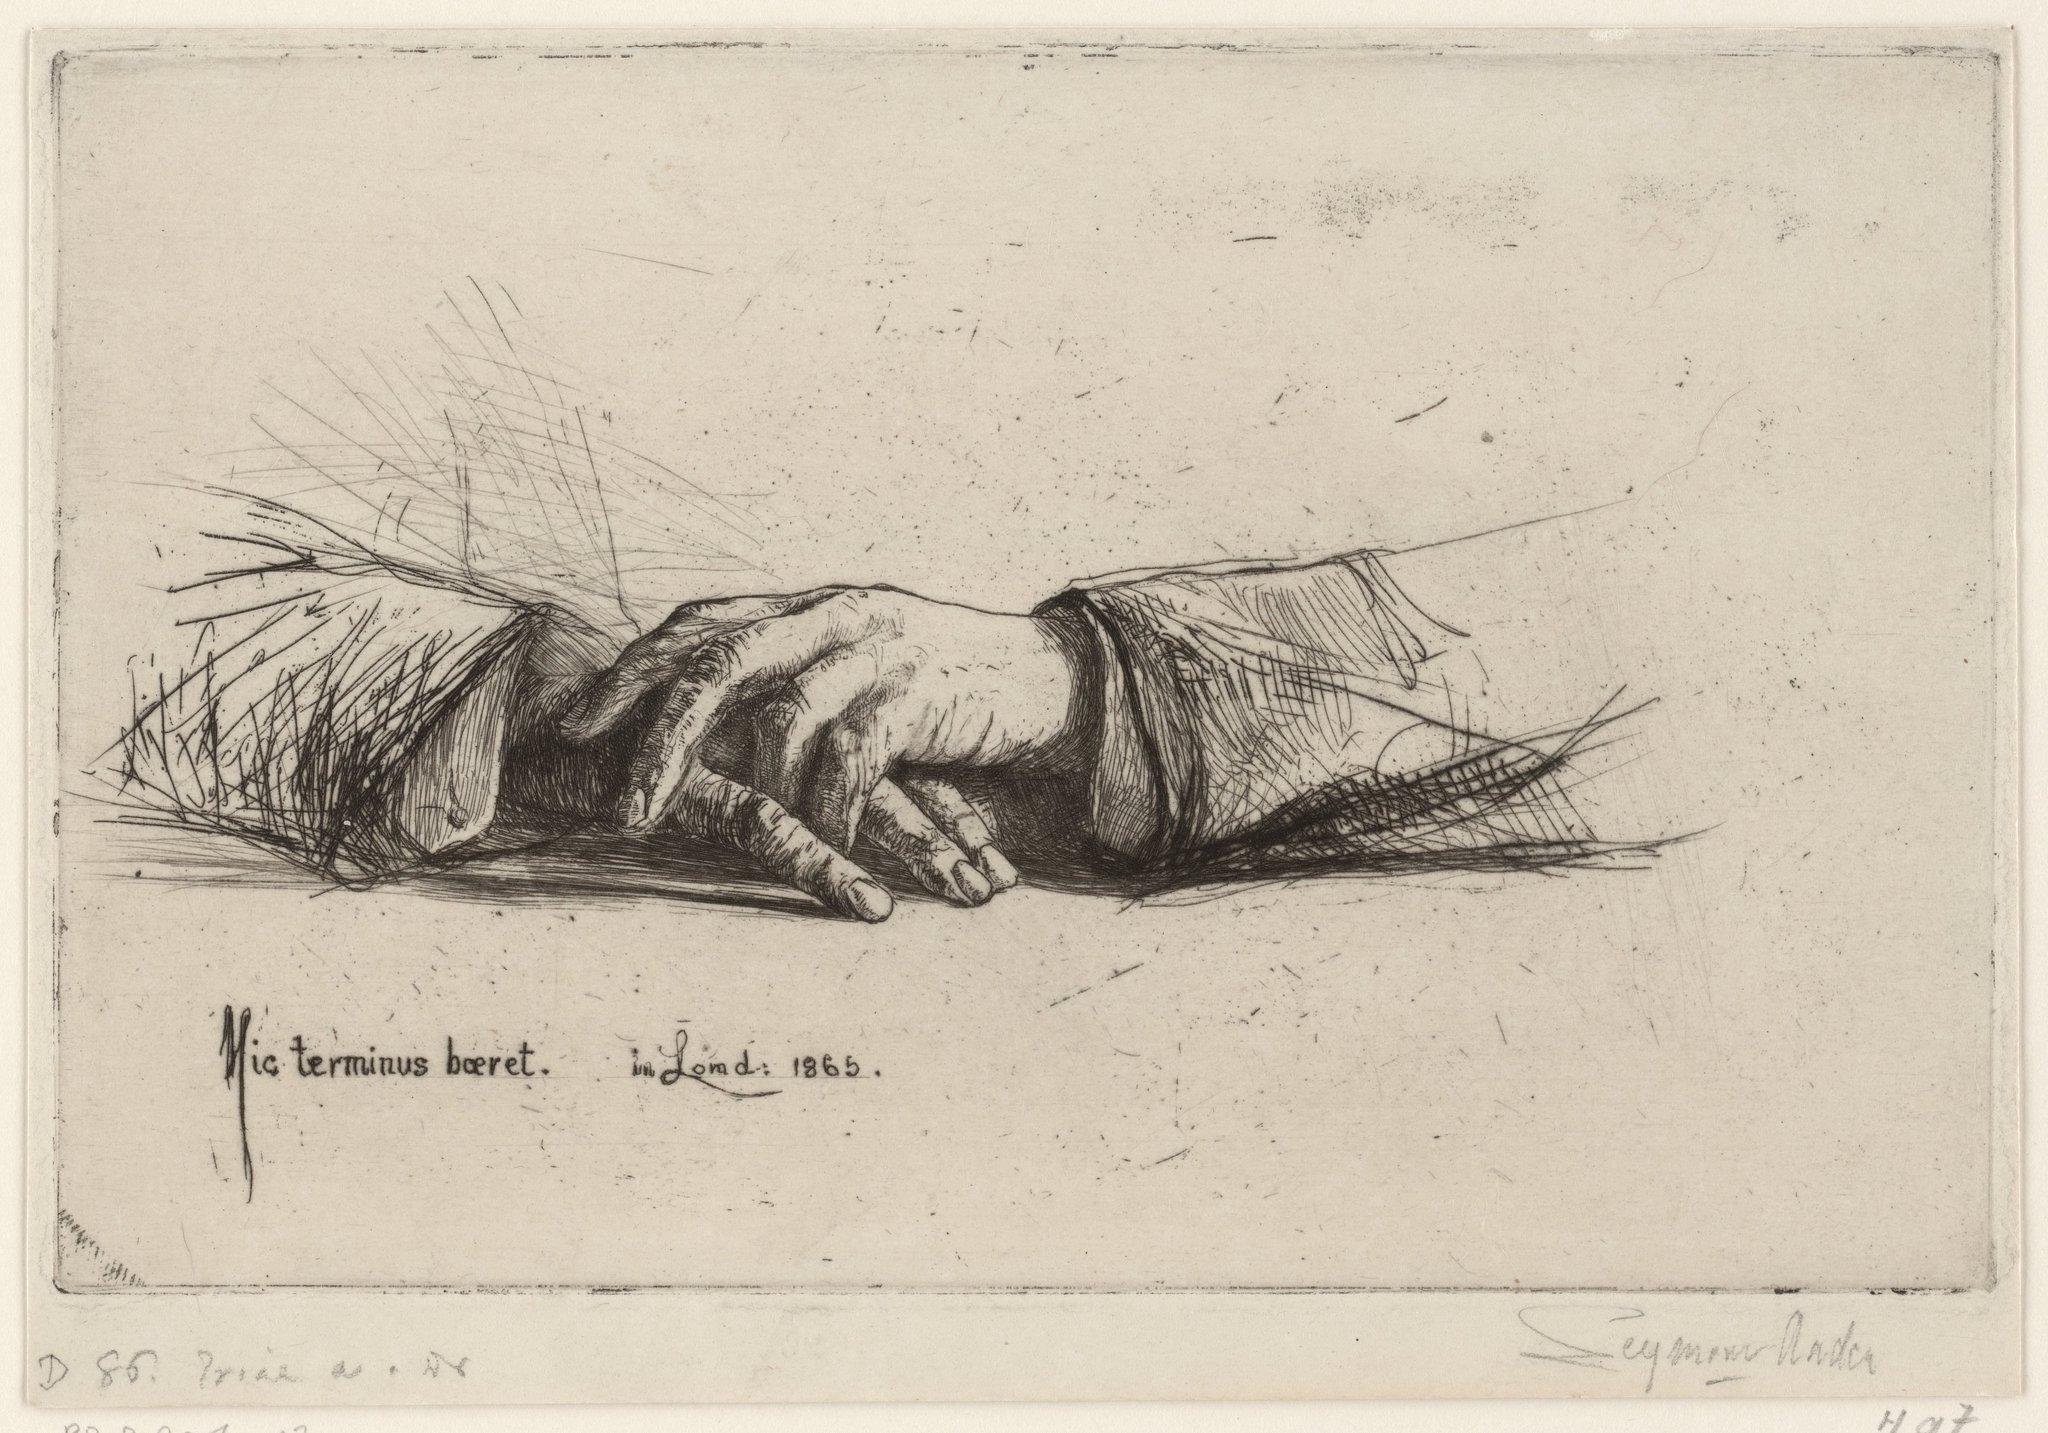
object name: print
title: Etudes à l'eau-forte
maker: francis seymour-haden (sir)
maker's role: print maker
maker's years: 1818-1910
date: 1865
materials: paper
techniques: drypoint, etching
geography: london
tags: hands folded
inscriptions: collector's mark: Lugt 2760, signature: ‘Seymour Haden’, collector's mark: Lugt 2228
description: De gevouwen handen van de kunstenaar, rustend op een niet nader gedefinieerde ondergrond. Met opschrift 'Hic terminus haeret': 'Hier is het eindpunt bereikt'. Dit blad heeft dienst gedaan als de laatste prent in de 'Etudes a l'eau-forte', een visuele grap van de kunstenaar.